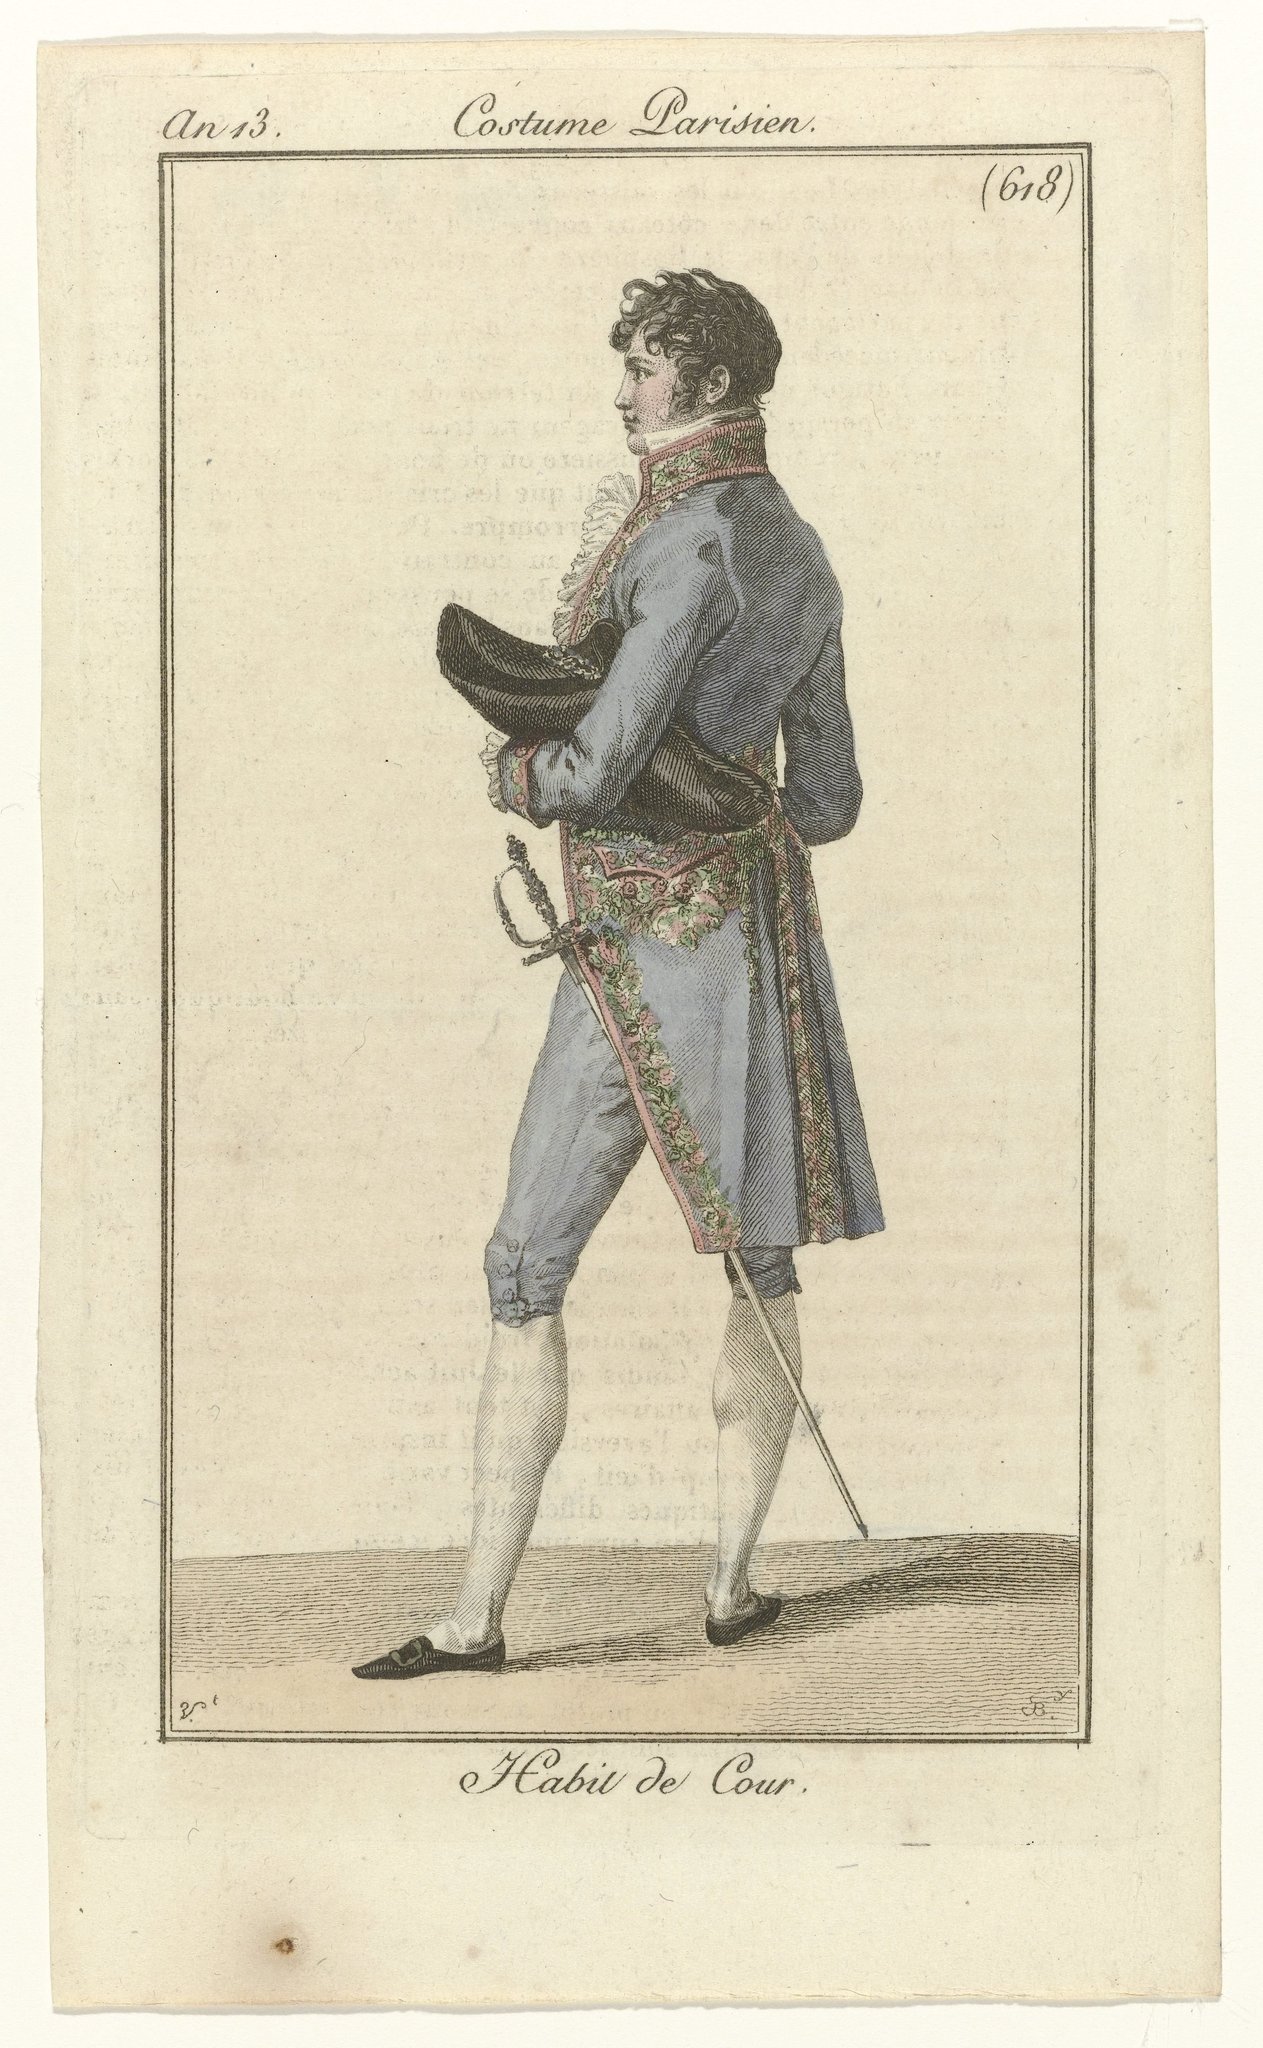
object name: fashion print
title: Journal des Dames et des Modes, Costume Parisien, 14 février 1805, An 13 (618) : Habit de Cour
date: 1805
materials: paper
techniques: engraving, hand coloring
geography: paris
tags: head-gear: tricorn (+ men's clothes), underclothes (+ men's clothes), hacking and thrusting weapons, coat (+ men's clothes), fashion plates, shoes, sandals (+ men's clothes), clothing for the upper part of the body (+ men's clothes), trousers, breeches, etc. (breeches) (+ men's clothes), stockings, socks (+ men's clothes)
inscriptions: title: ‘Costume Parisien.’, caption: ‘Habit de Cour’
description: Hofkostuum: frak afgezet met bloempatroon, kniebroek, hemd met geplooide jabot en manchetten. Witte kousen. Hoed onder de arm, (sier)degen aan de linkerzijde, platte schoenen met vierkante gespen. De prent maakt deel uit van het modetijdschrift Journal des Dames et des Modes, uitgegeven door Pierre de la Mésangère, Parijs, 1797-1839.